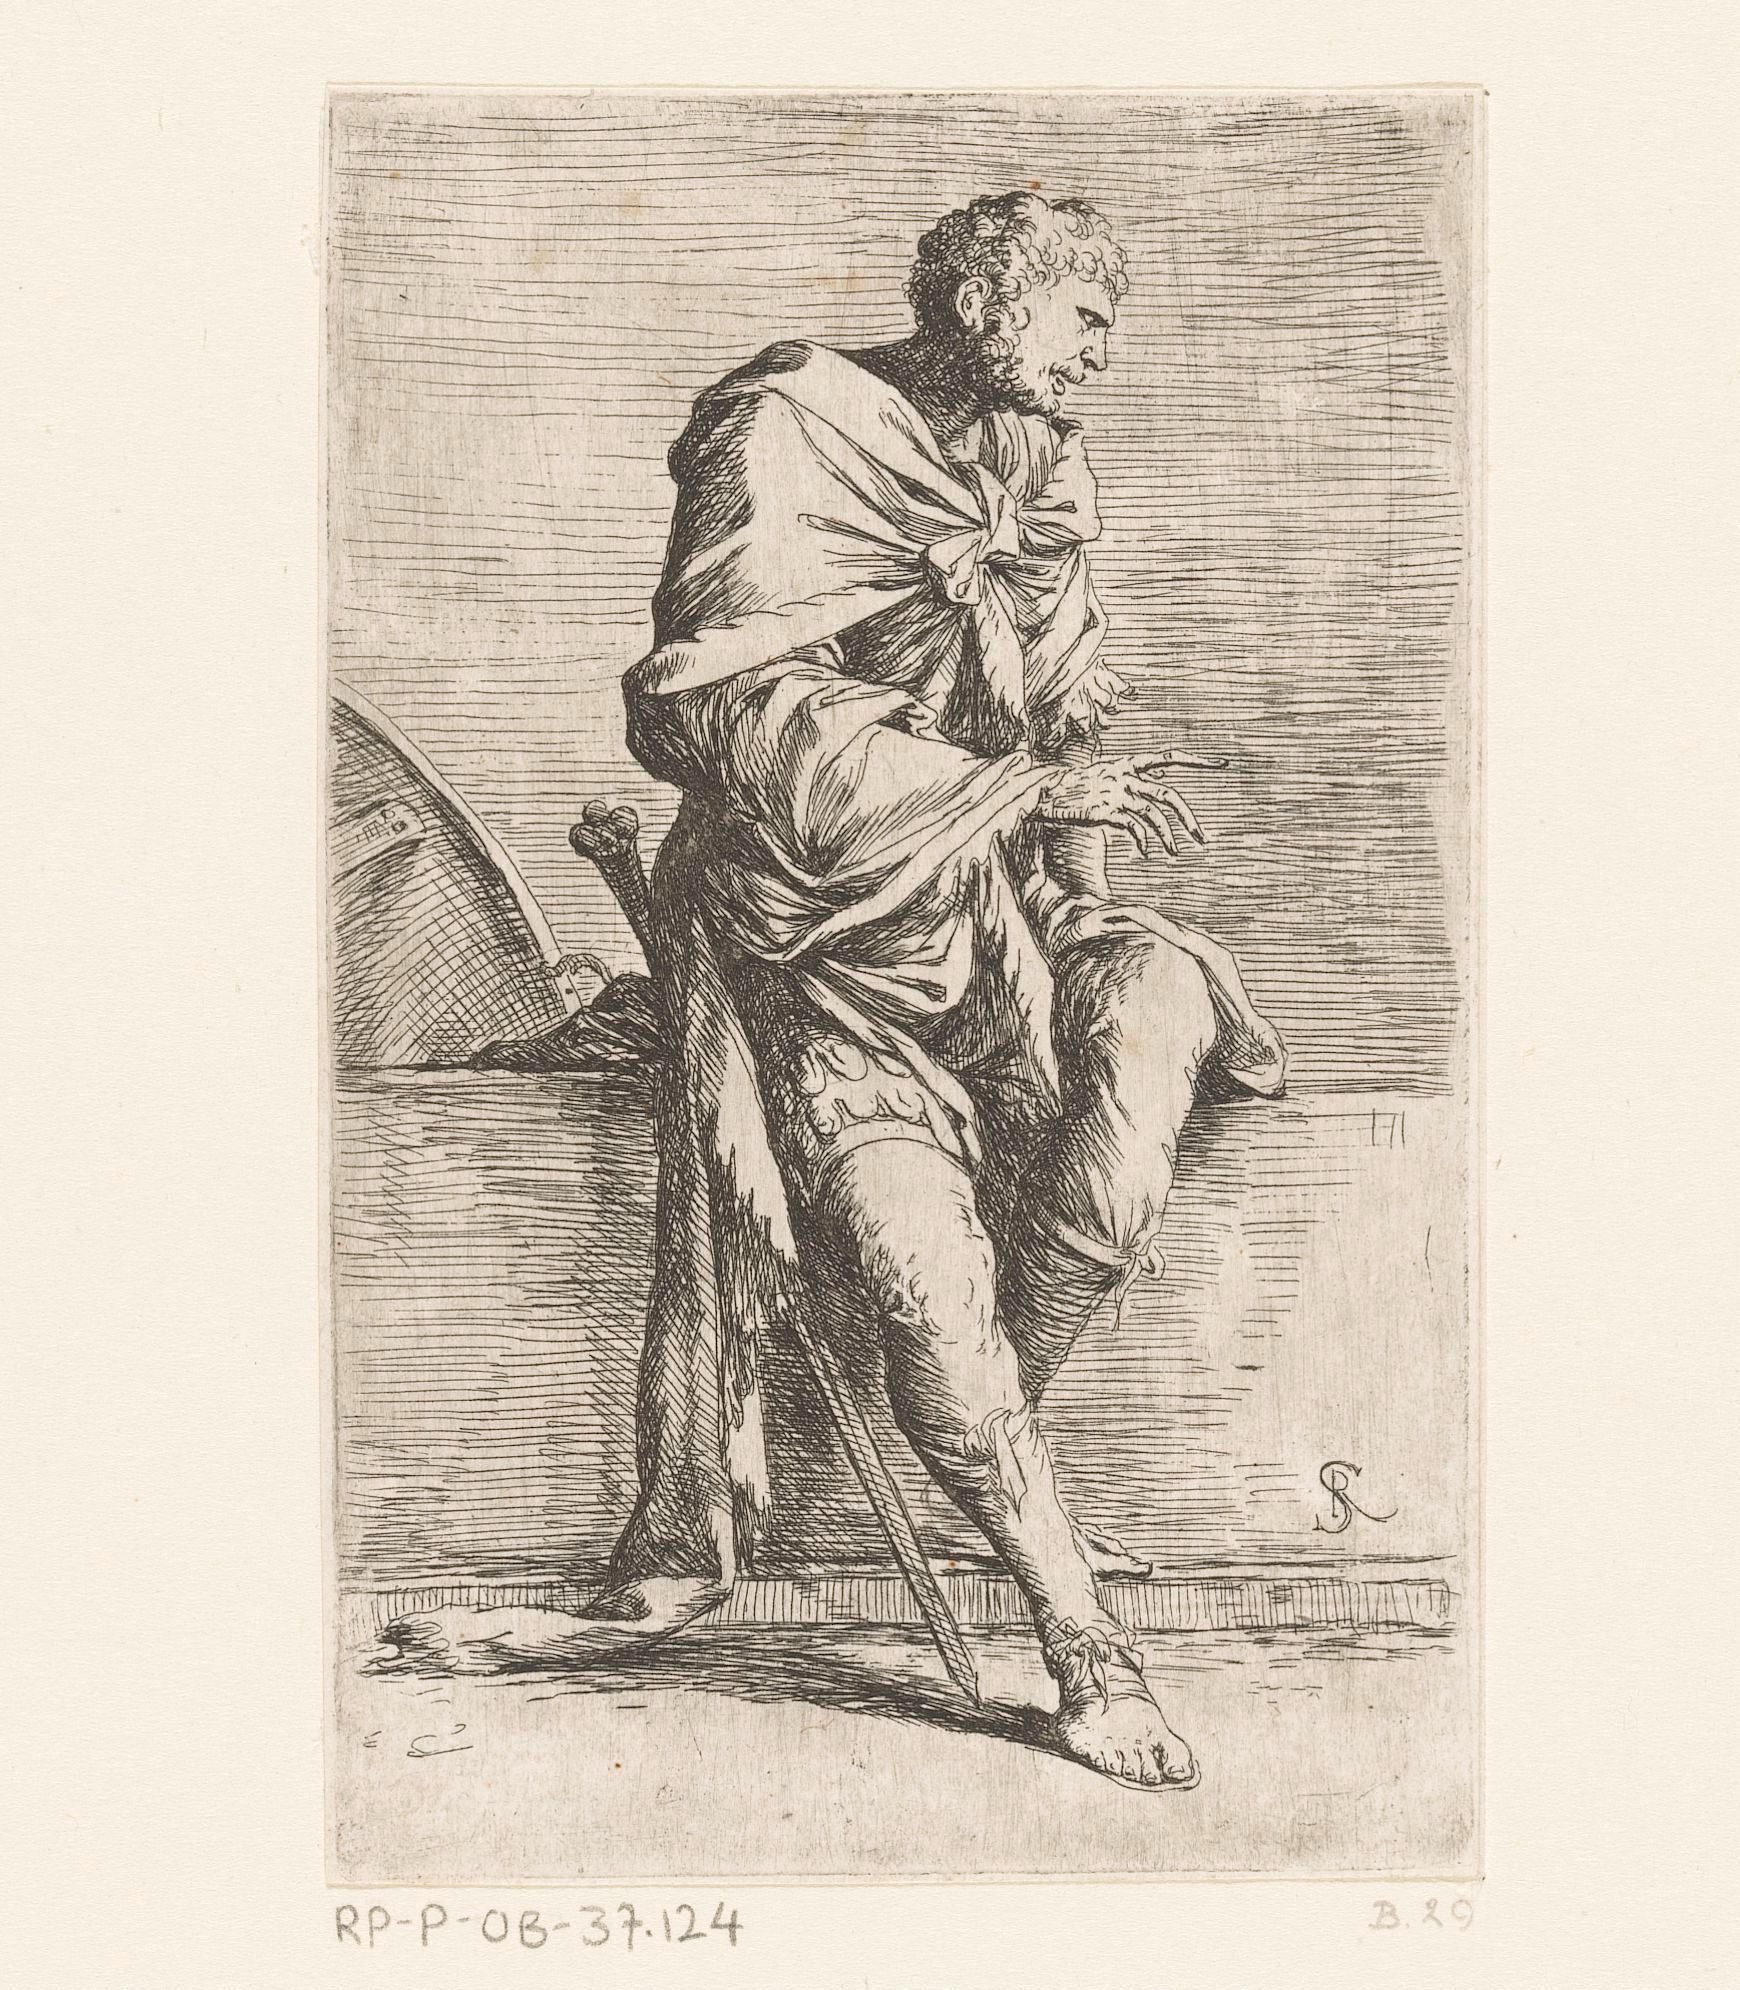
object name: print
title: Figurine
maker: salvator rosa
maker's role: draughtsman, painter, print maker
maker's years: 1615-1673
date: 1656-1657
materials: paper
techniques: drypoint, etching, intaglio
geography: italy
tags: hacking and thrusting weapons: sword, the soldier; the soldier's life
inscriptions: collector's mark: Lugt 240, number: ‘4’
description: Deze prent maakt deel uit van de serie 'Figurine', bestaande uit een titelprent en 80 prenten van klein formaat met voorstellingen van mannelijke en vrouwelijke figuren. Rosa produceerde de serie waarschijnlijk gedurende de jaren 1656 en 1657.